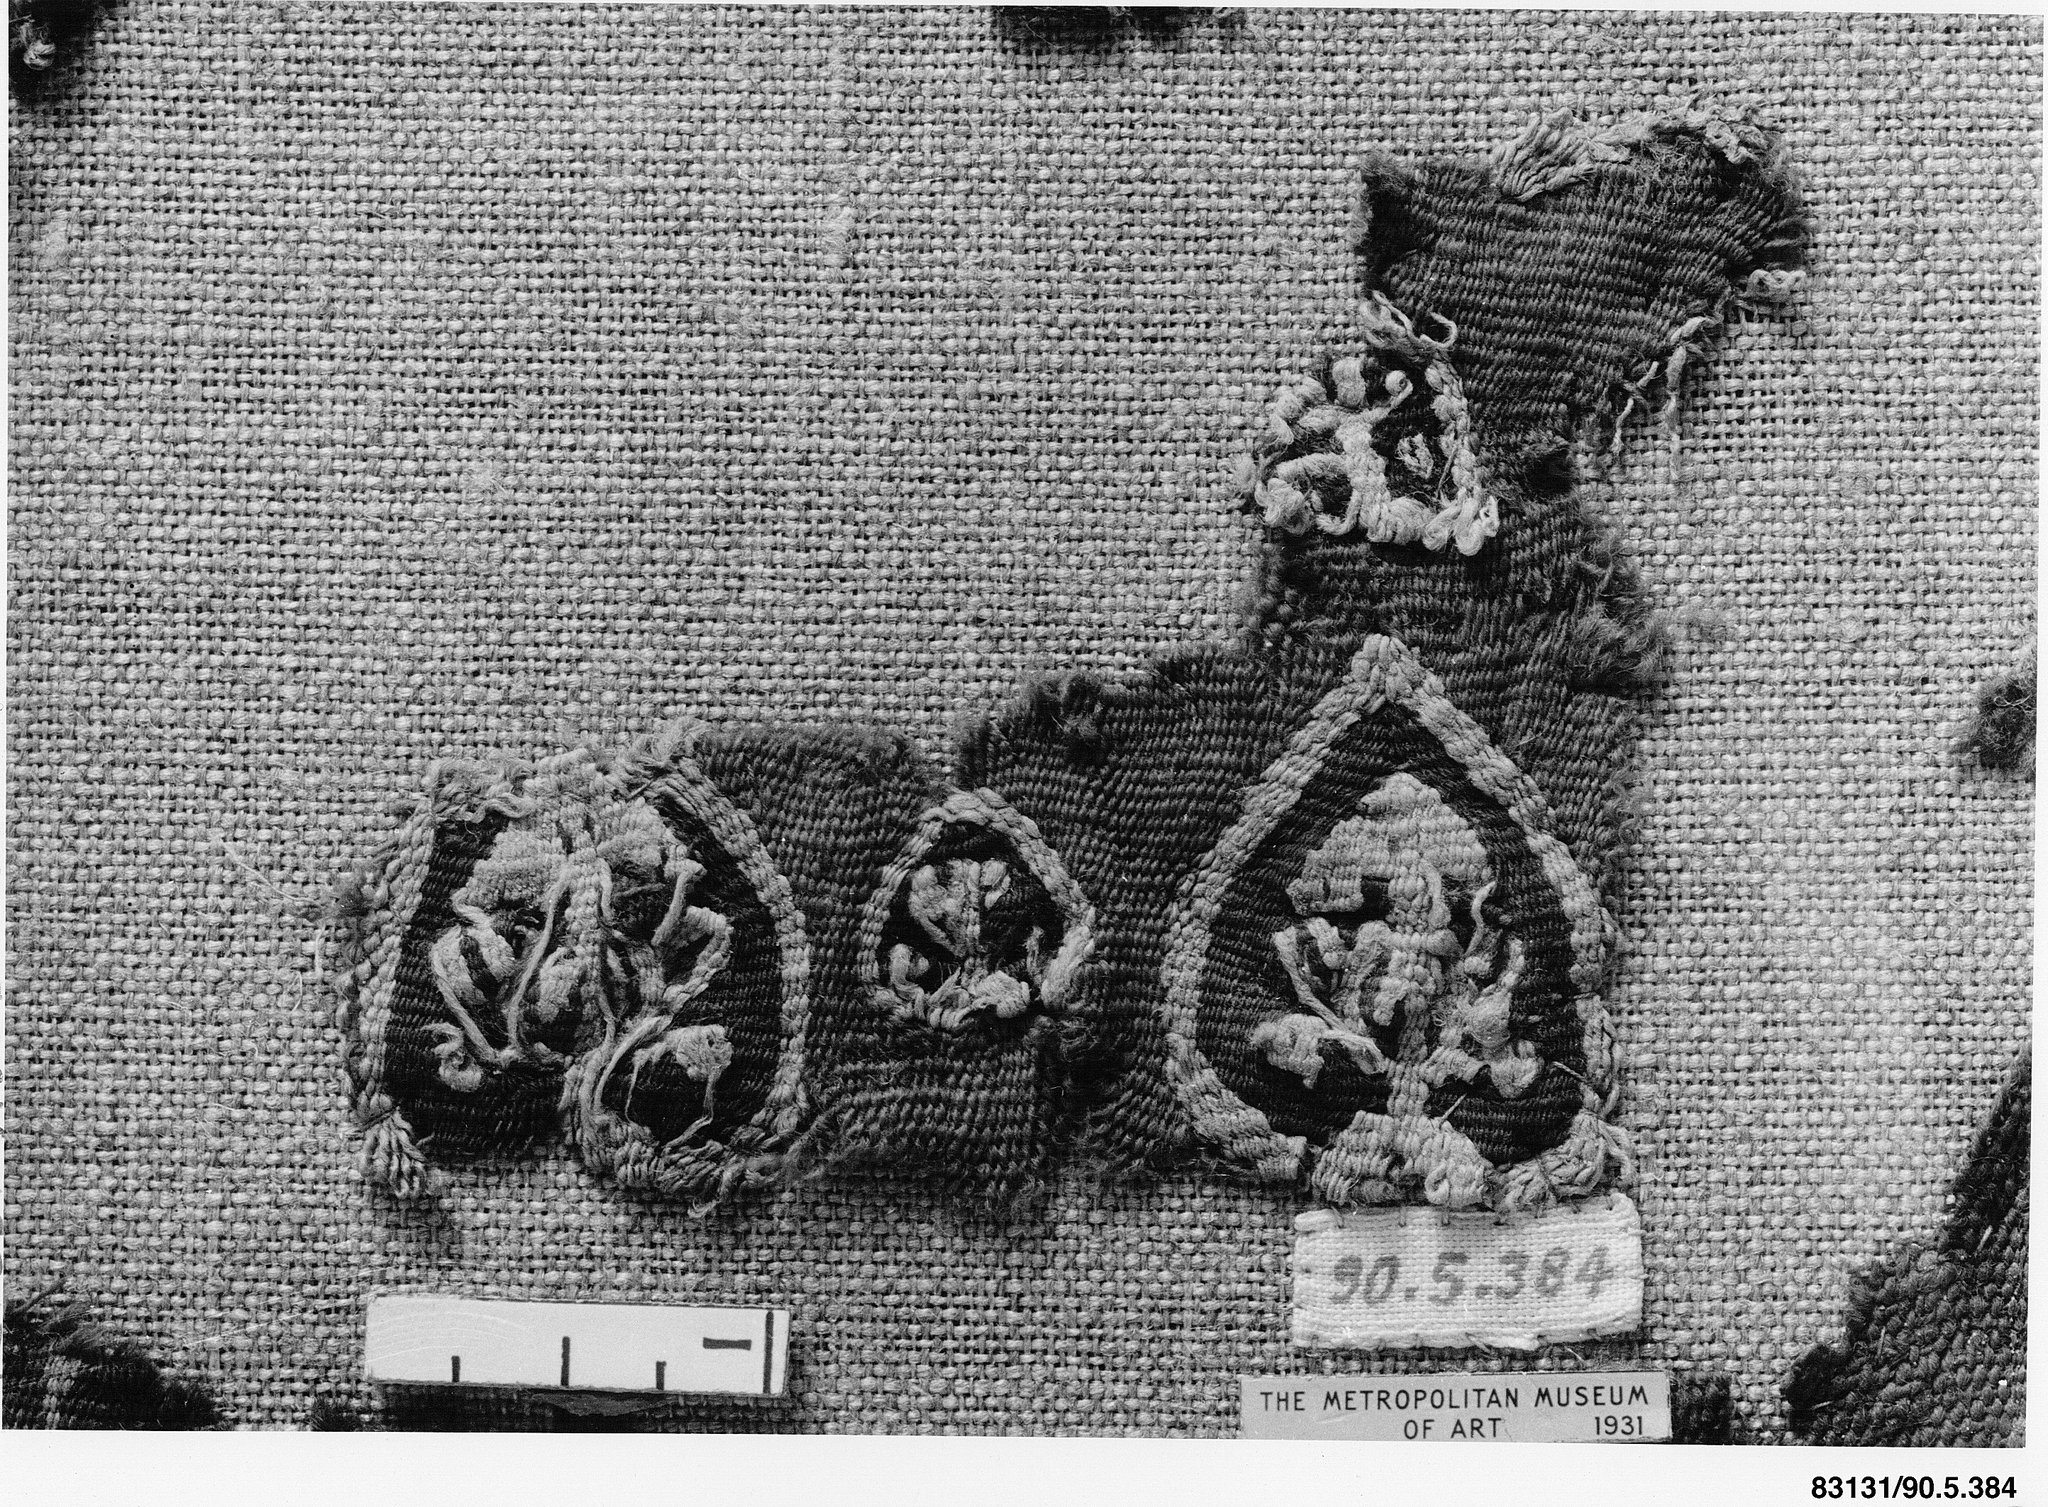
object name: textile fragment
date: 301-500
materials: linen, wool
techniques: weave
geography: egypt